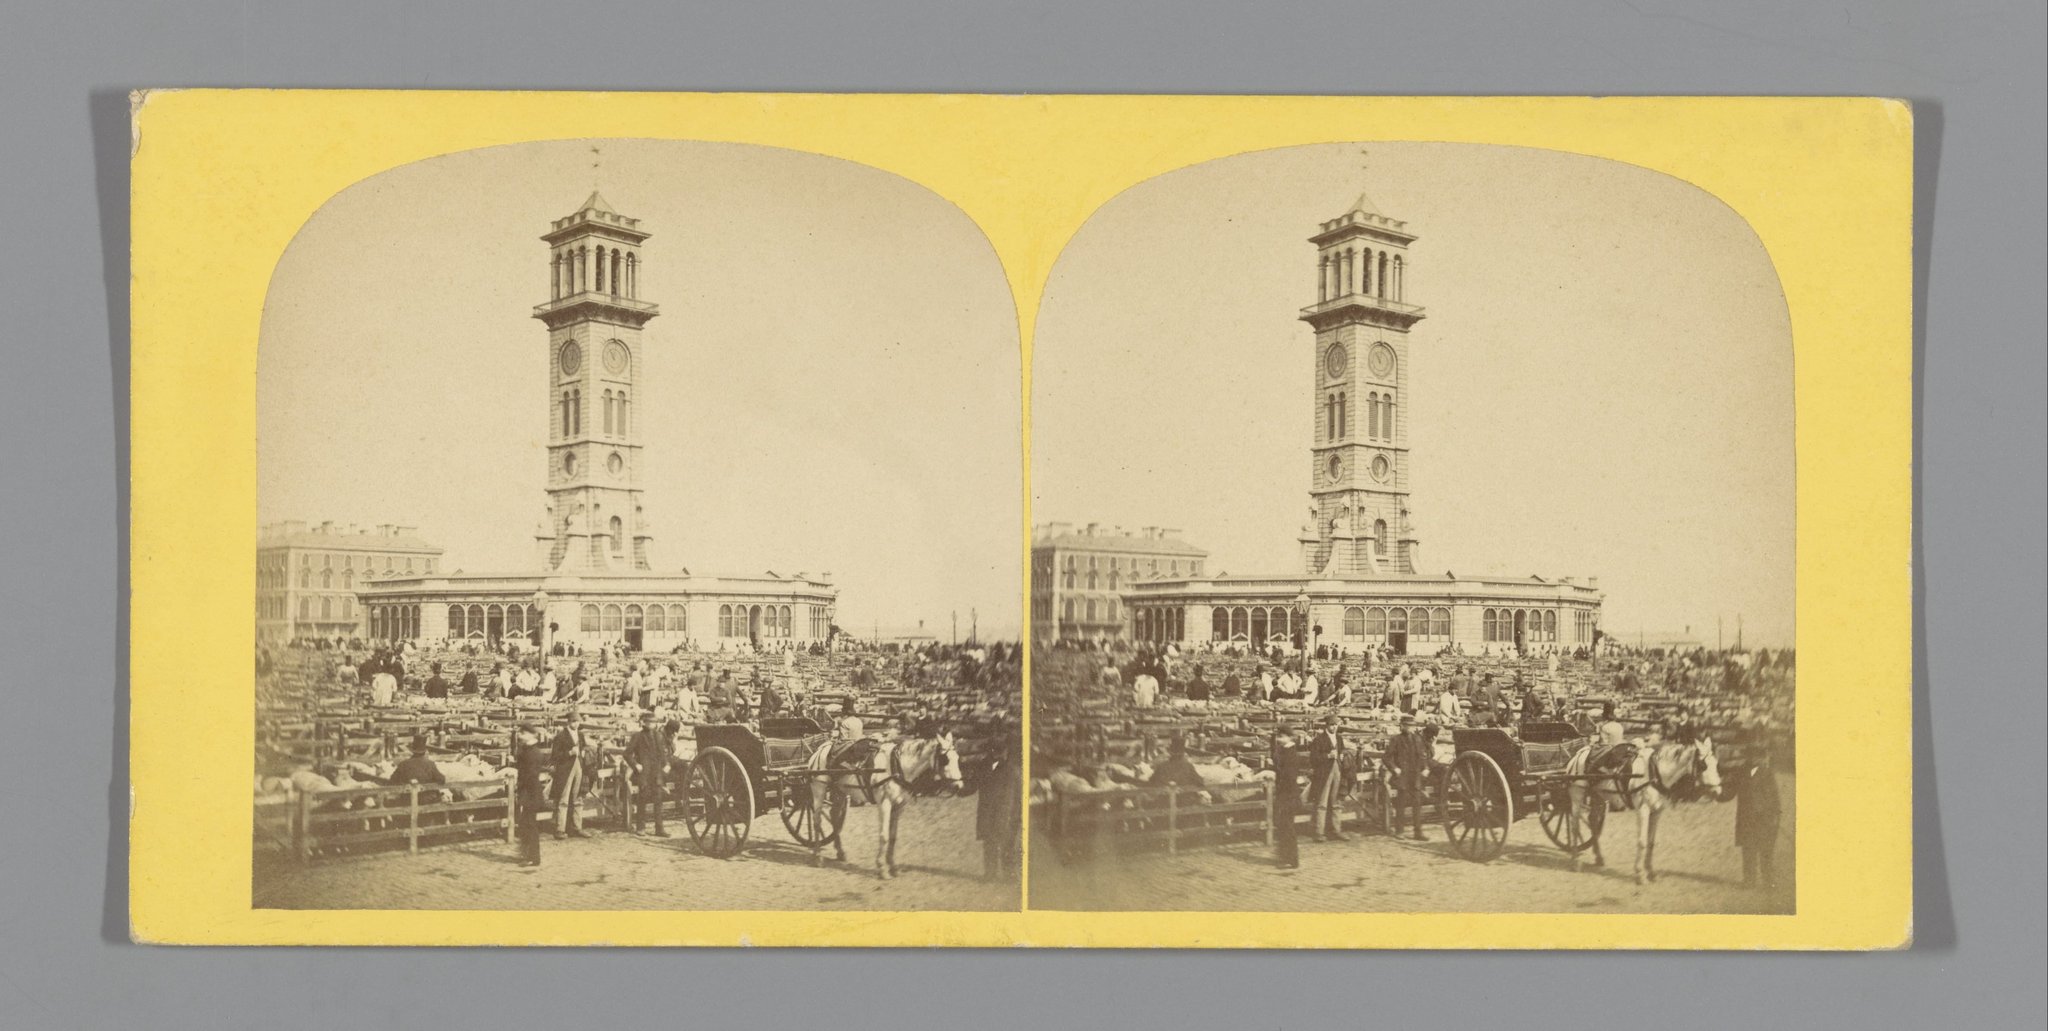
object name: stereograph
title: Instantaneous Views of London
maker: Anonymous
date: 1850-1880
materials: cardboard, photographic support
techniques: albumen print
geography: london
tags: market, london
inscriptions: inscription, number: ‘No. 191.’